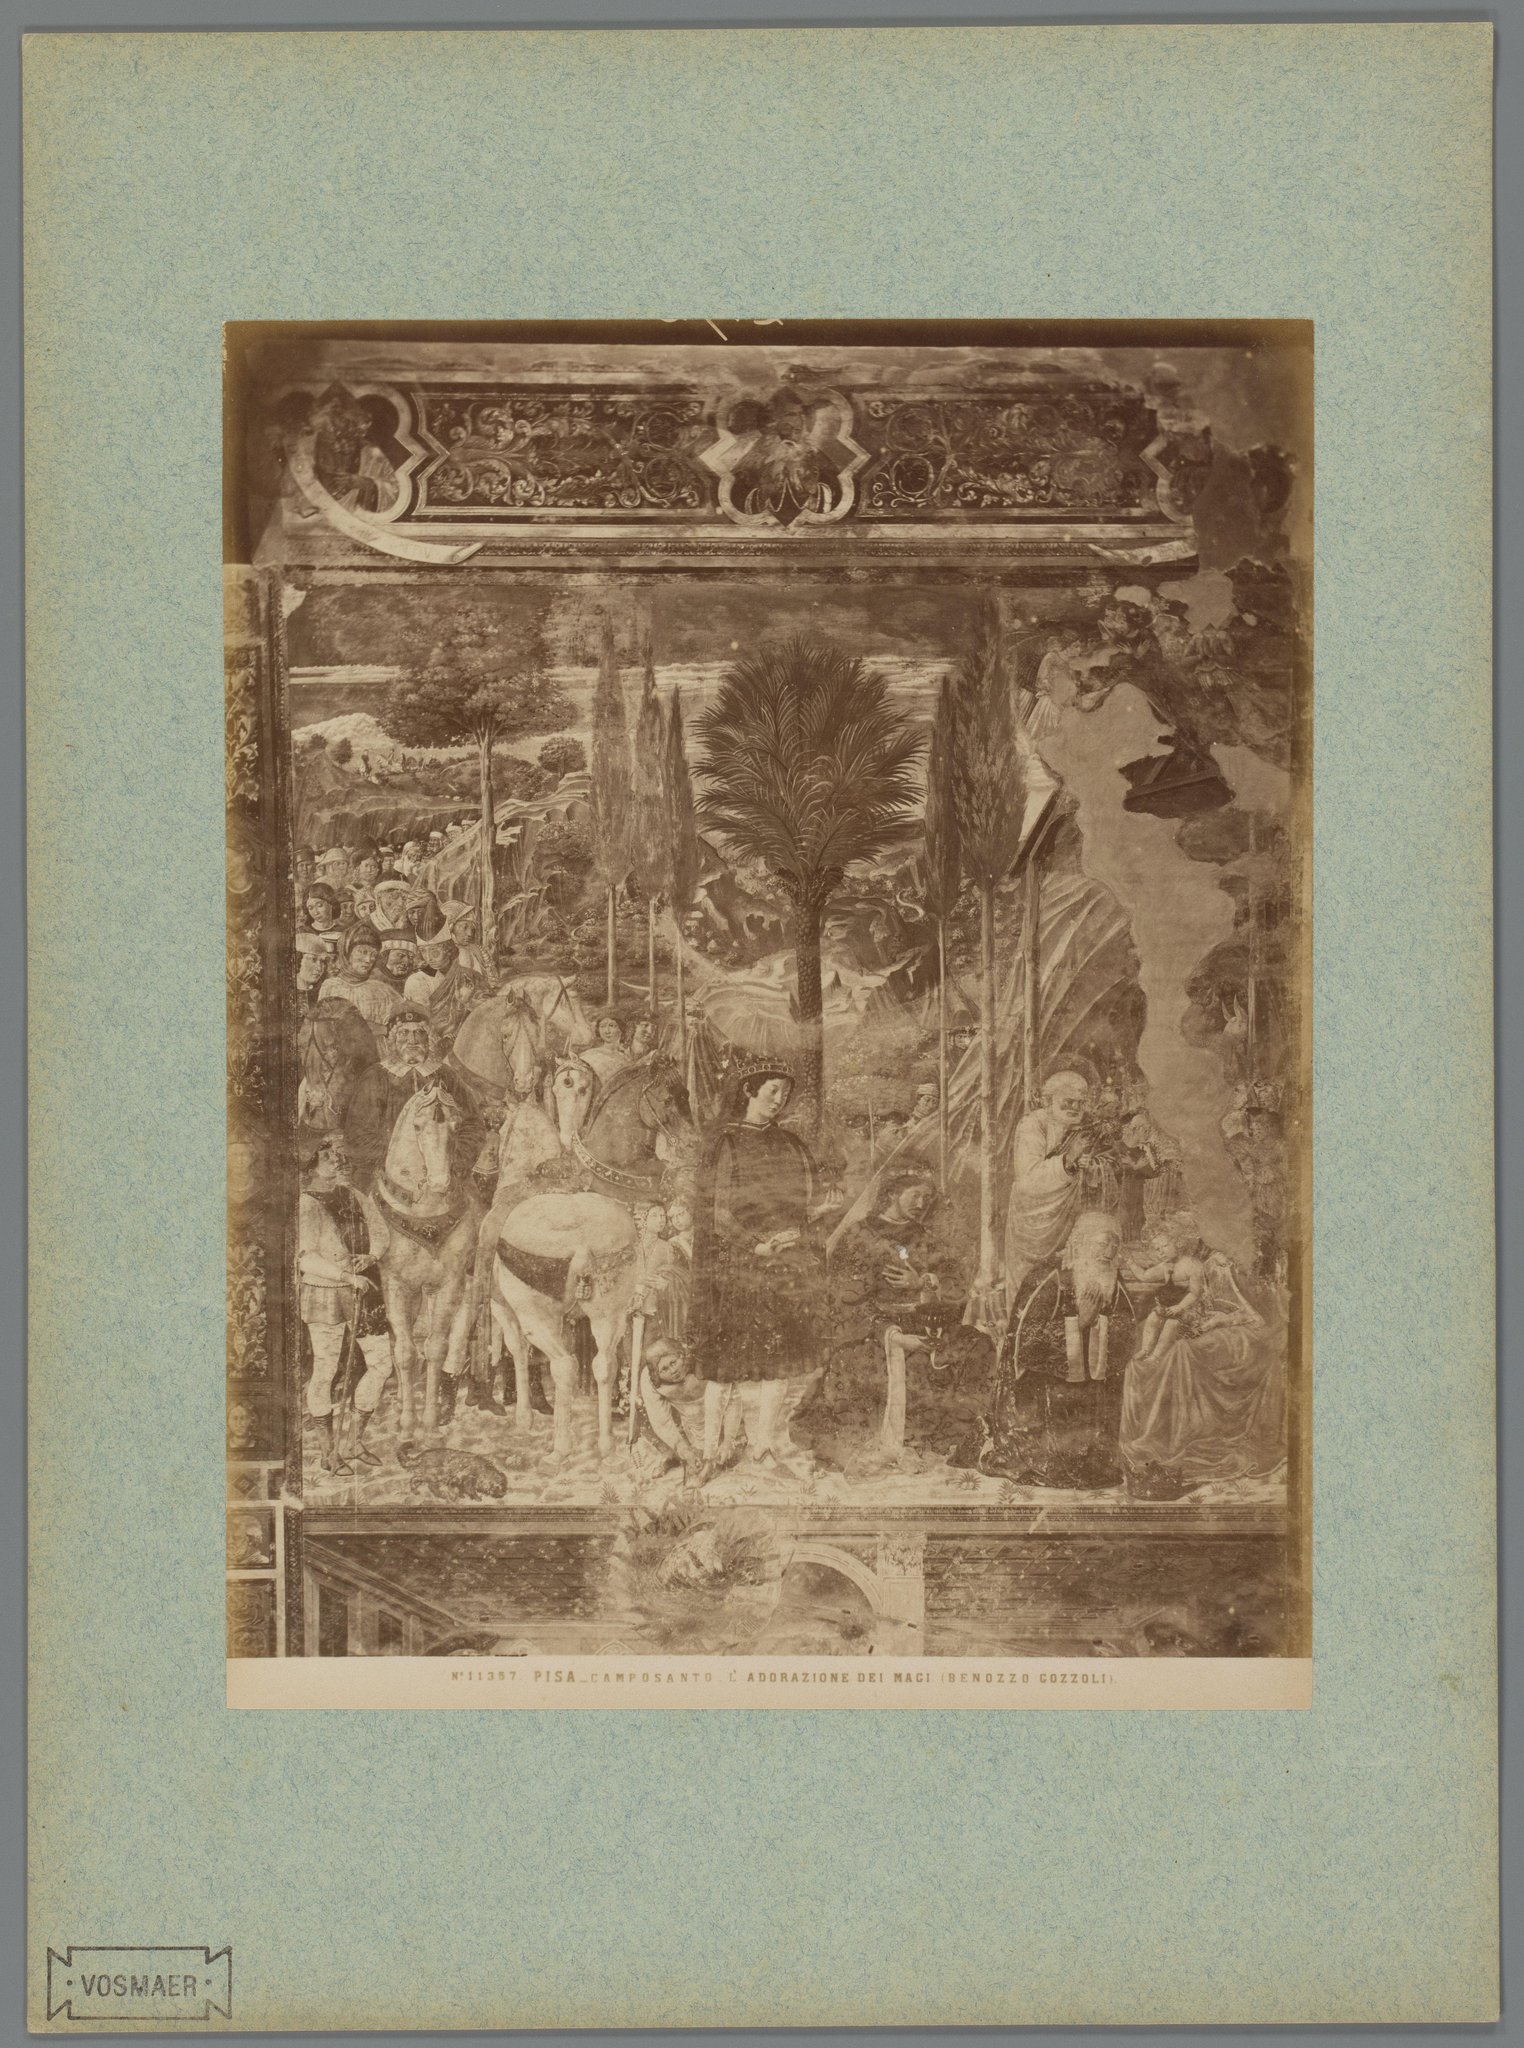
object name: reproduction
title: Fotoreproductie van het fresco De aanbidding van de wijzen door Benozzo Gozzoli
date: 1851-1900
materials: cardboard, paper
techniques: albumen print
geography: pisa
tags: wall-covering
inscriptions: number: ‘No. 11357’, collector's mark: ‘VOSMAER’